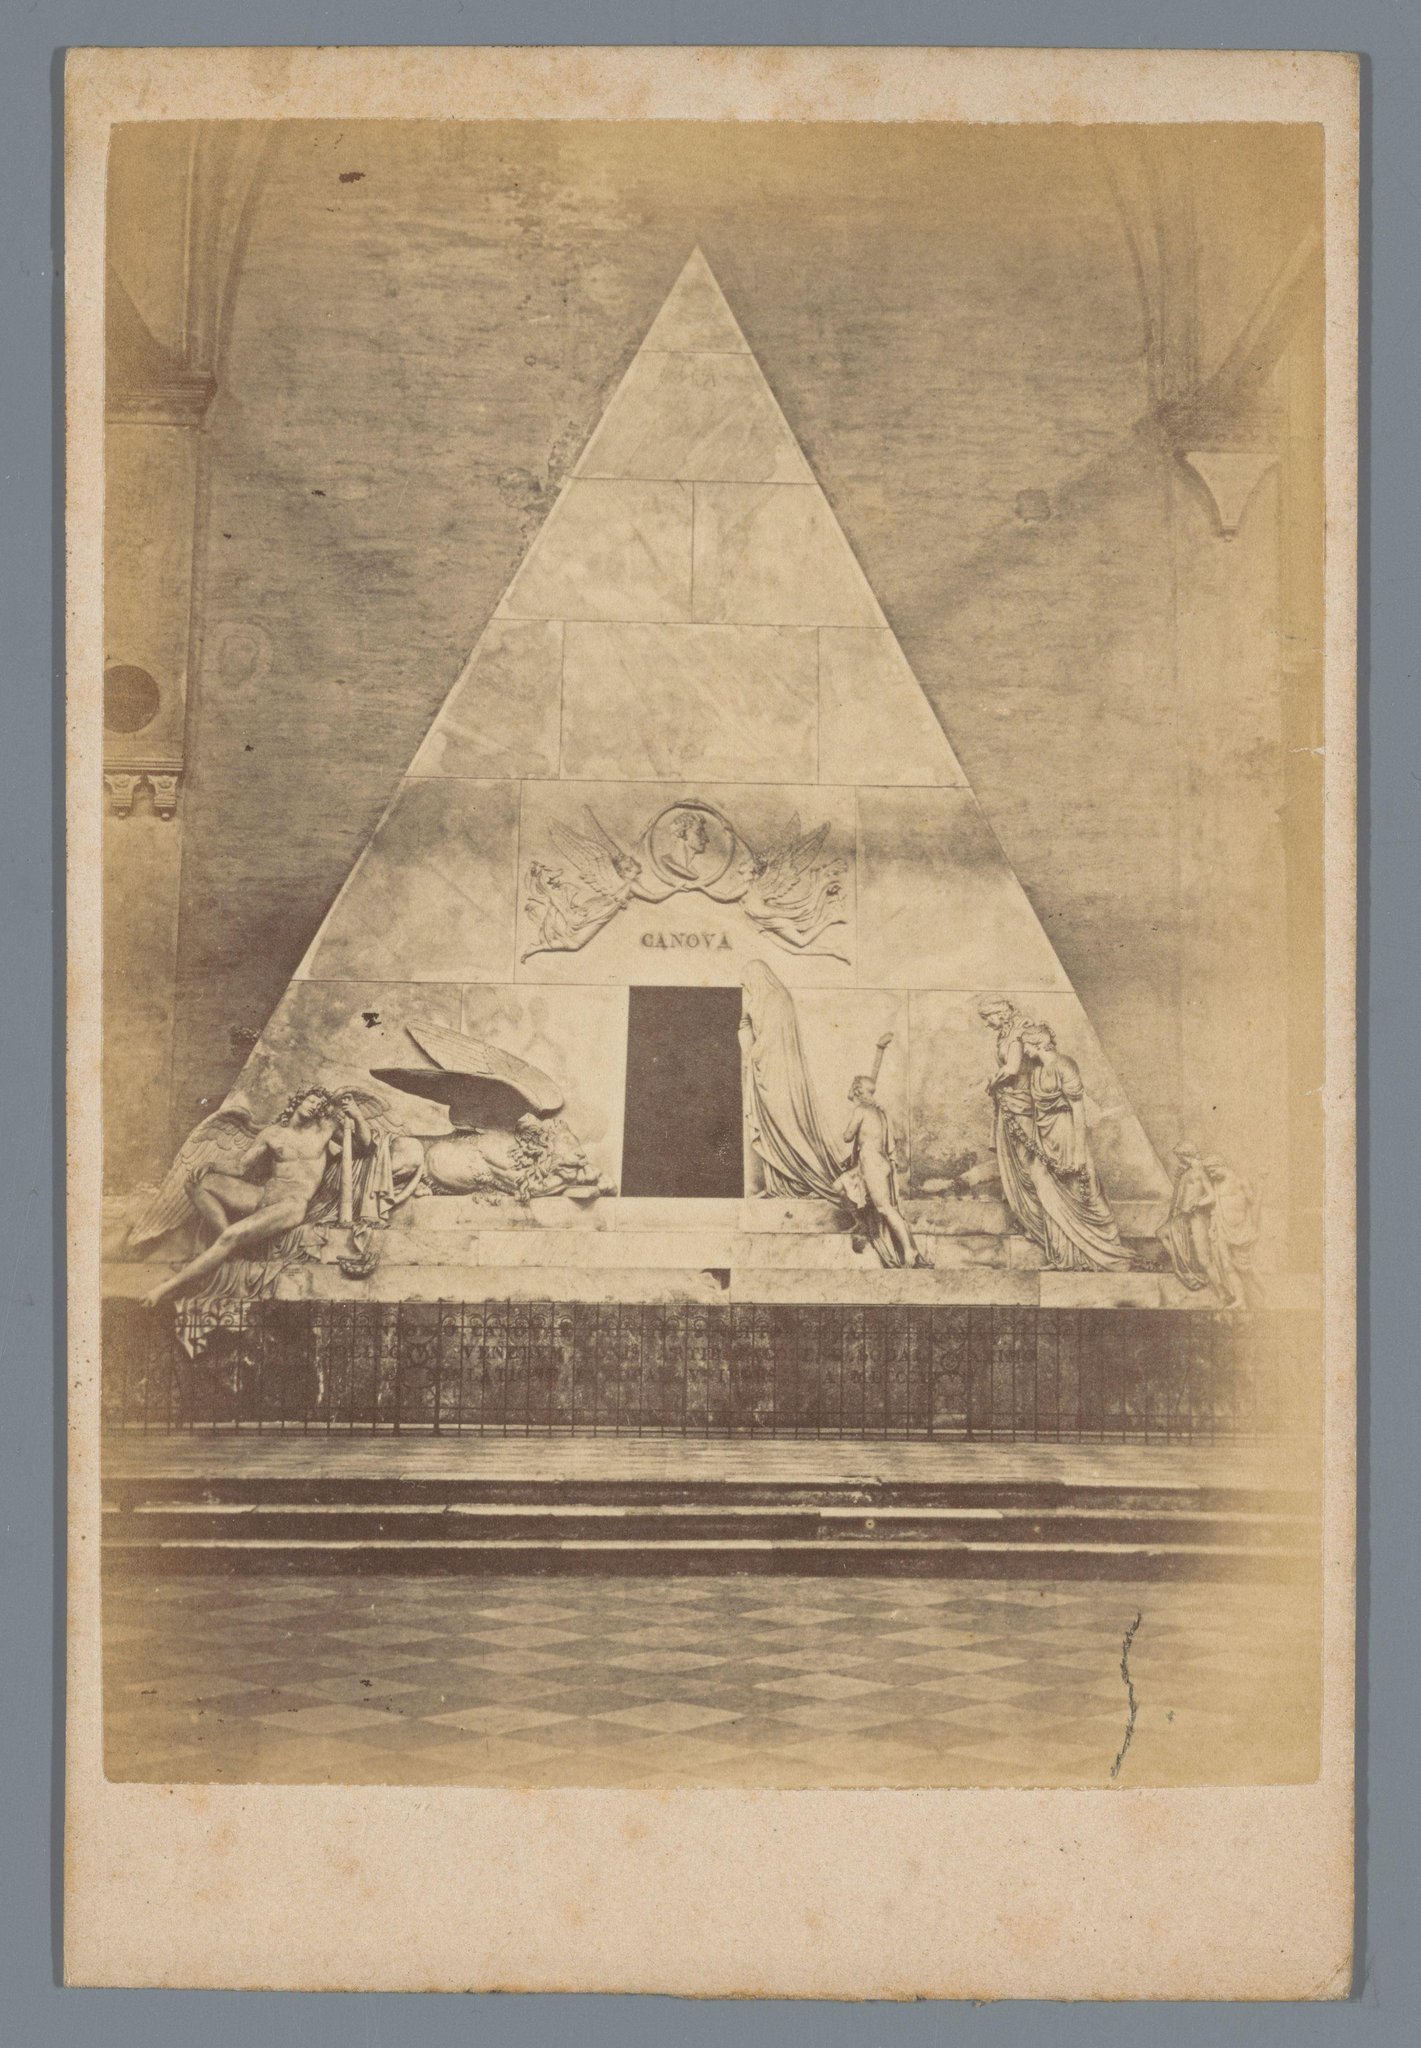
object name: cabinet photograph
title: Het grafmonument van Antonio Canova in de Basilica Santa Maria Gloriosa dei Frari in Venetië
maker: Anonymous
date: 1850-1900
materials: cardboard, photographic support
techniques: albumen print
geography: basilica di santa maria gloriosa dei frari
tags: venice, painter, draughtsman, sculptor, antonio canova, grave, tomb, parts of church interior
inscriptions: annotation: ‘Venezia tombe d' Canova’